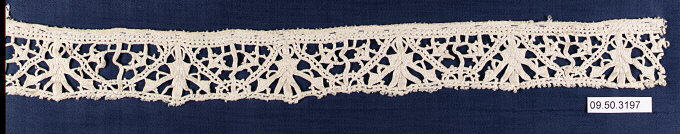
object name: strip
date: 1601-1700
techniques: lace